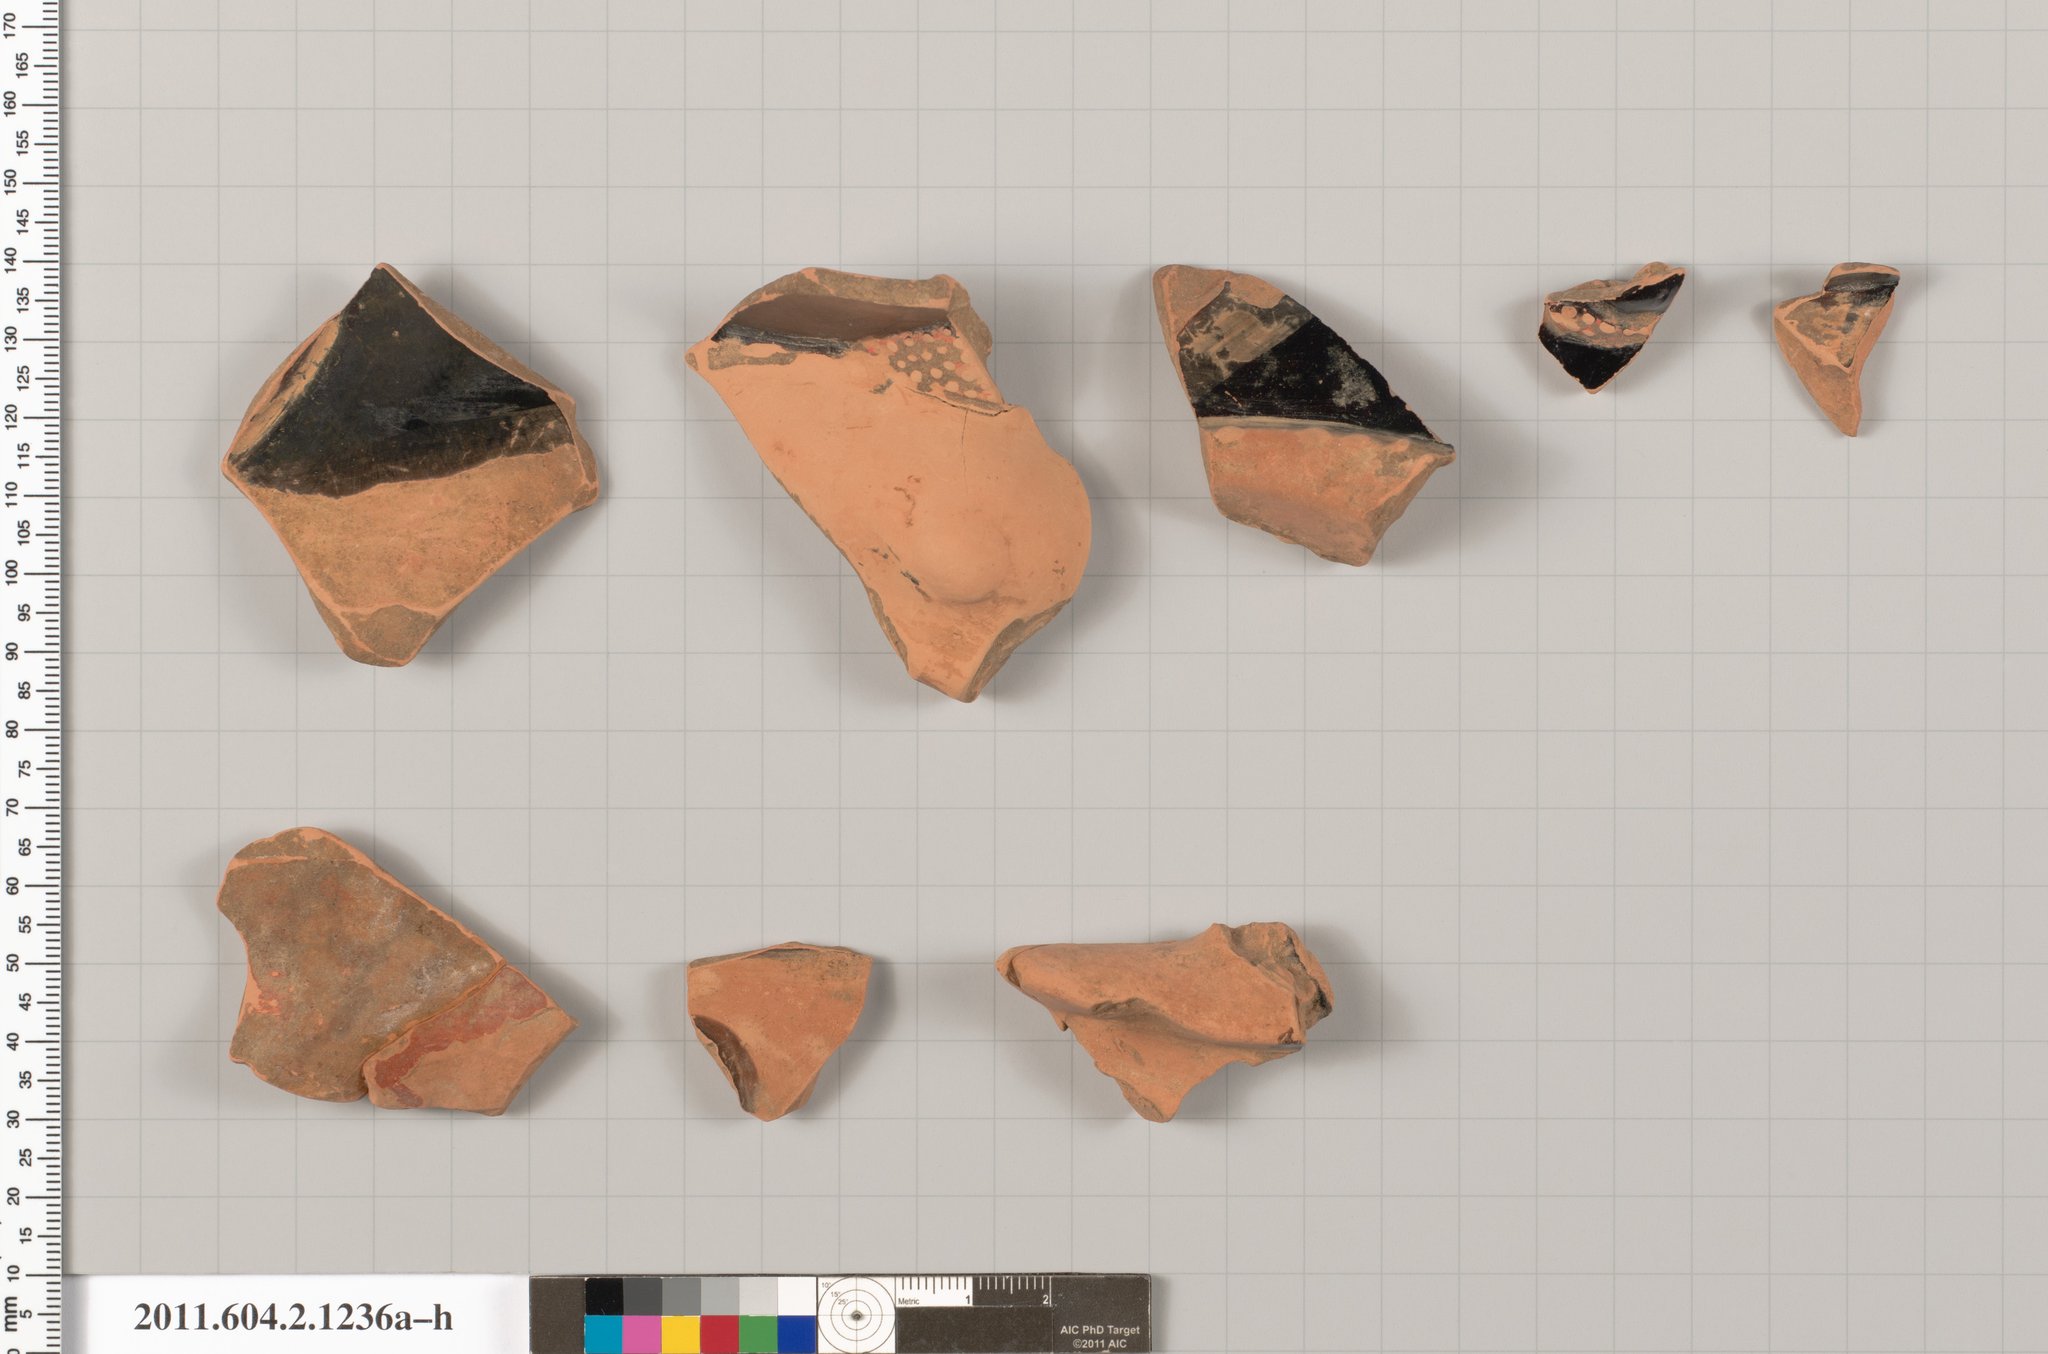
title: Terracotta fragments from a plastic vase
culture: greek, attic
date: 475-451 BCE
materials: terracotta